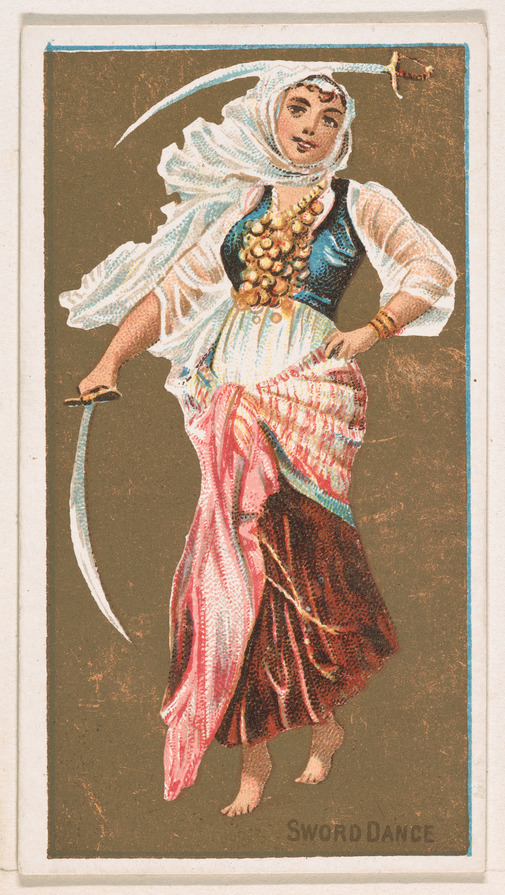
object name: print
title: Sword Dance, from National Dances (N225, Type 1) issued by Kinney Bros.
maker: kinney brothers tobacco company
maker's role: publisher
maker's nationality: american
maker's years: 1869-2011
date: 1889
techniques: color lithograph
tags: dance,swords,women,dancers